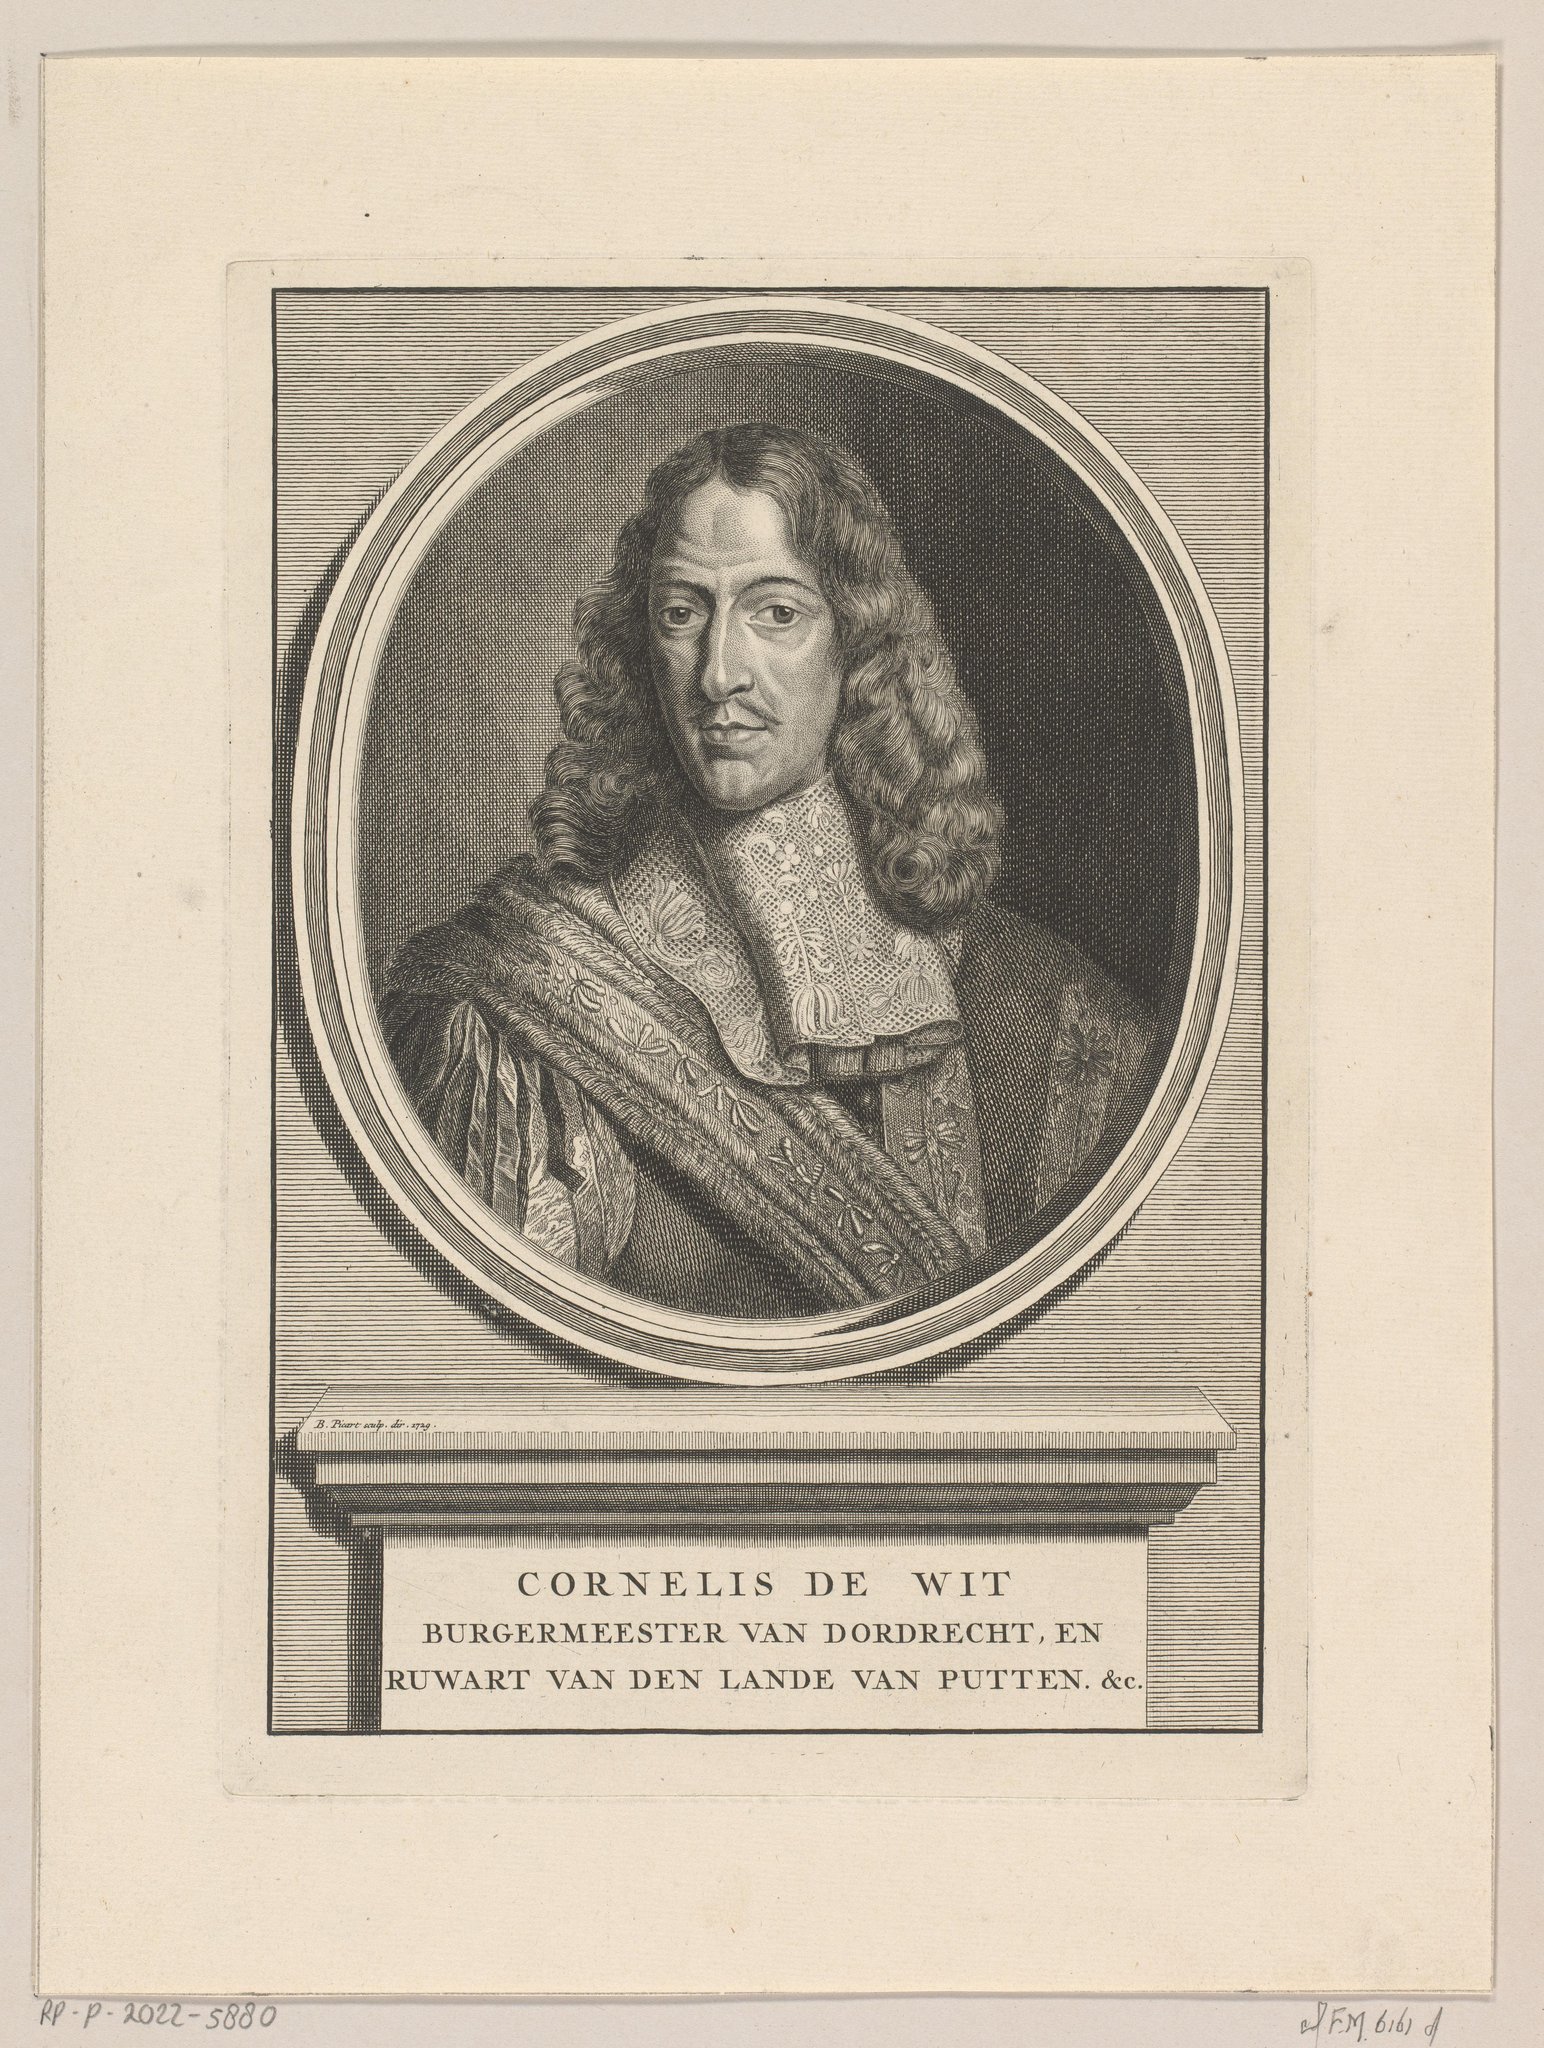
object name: book illustration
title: Portret van Cornelis de Witt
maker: bernard picart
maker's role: draughtsman, print maker, publisher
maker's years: 1673-1733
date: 1729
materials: paper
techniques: engraving, etching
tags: dordrecht, the hague, cornelis de witt, historical persons, governor, etc. of province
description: Latere staat gebruikt in: Le Clerc, Jean. Geschiedenissen der Vereenigde Nederlanden (...). Amsterdam: Zacharias Chatelain, 1730, dl. 3, 262.